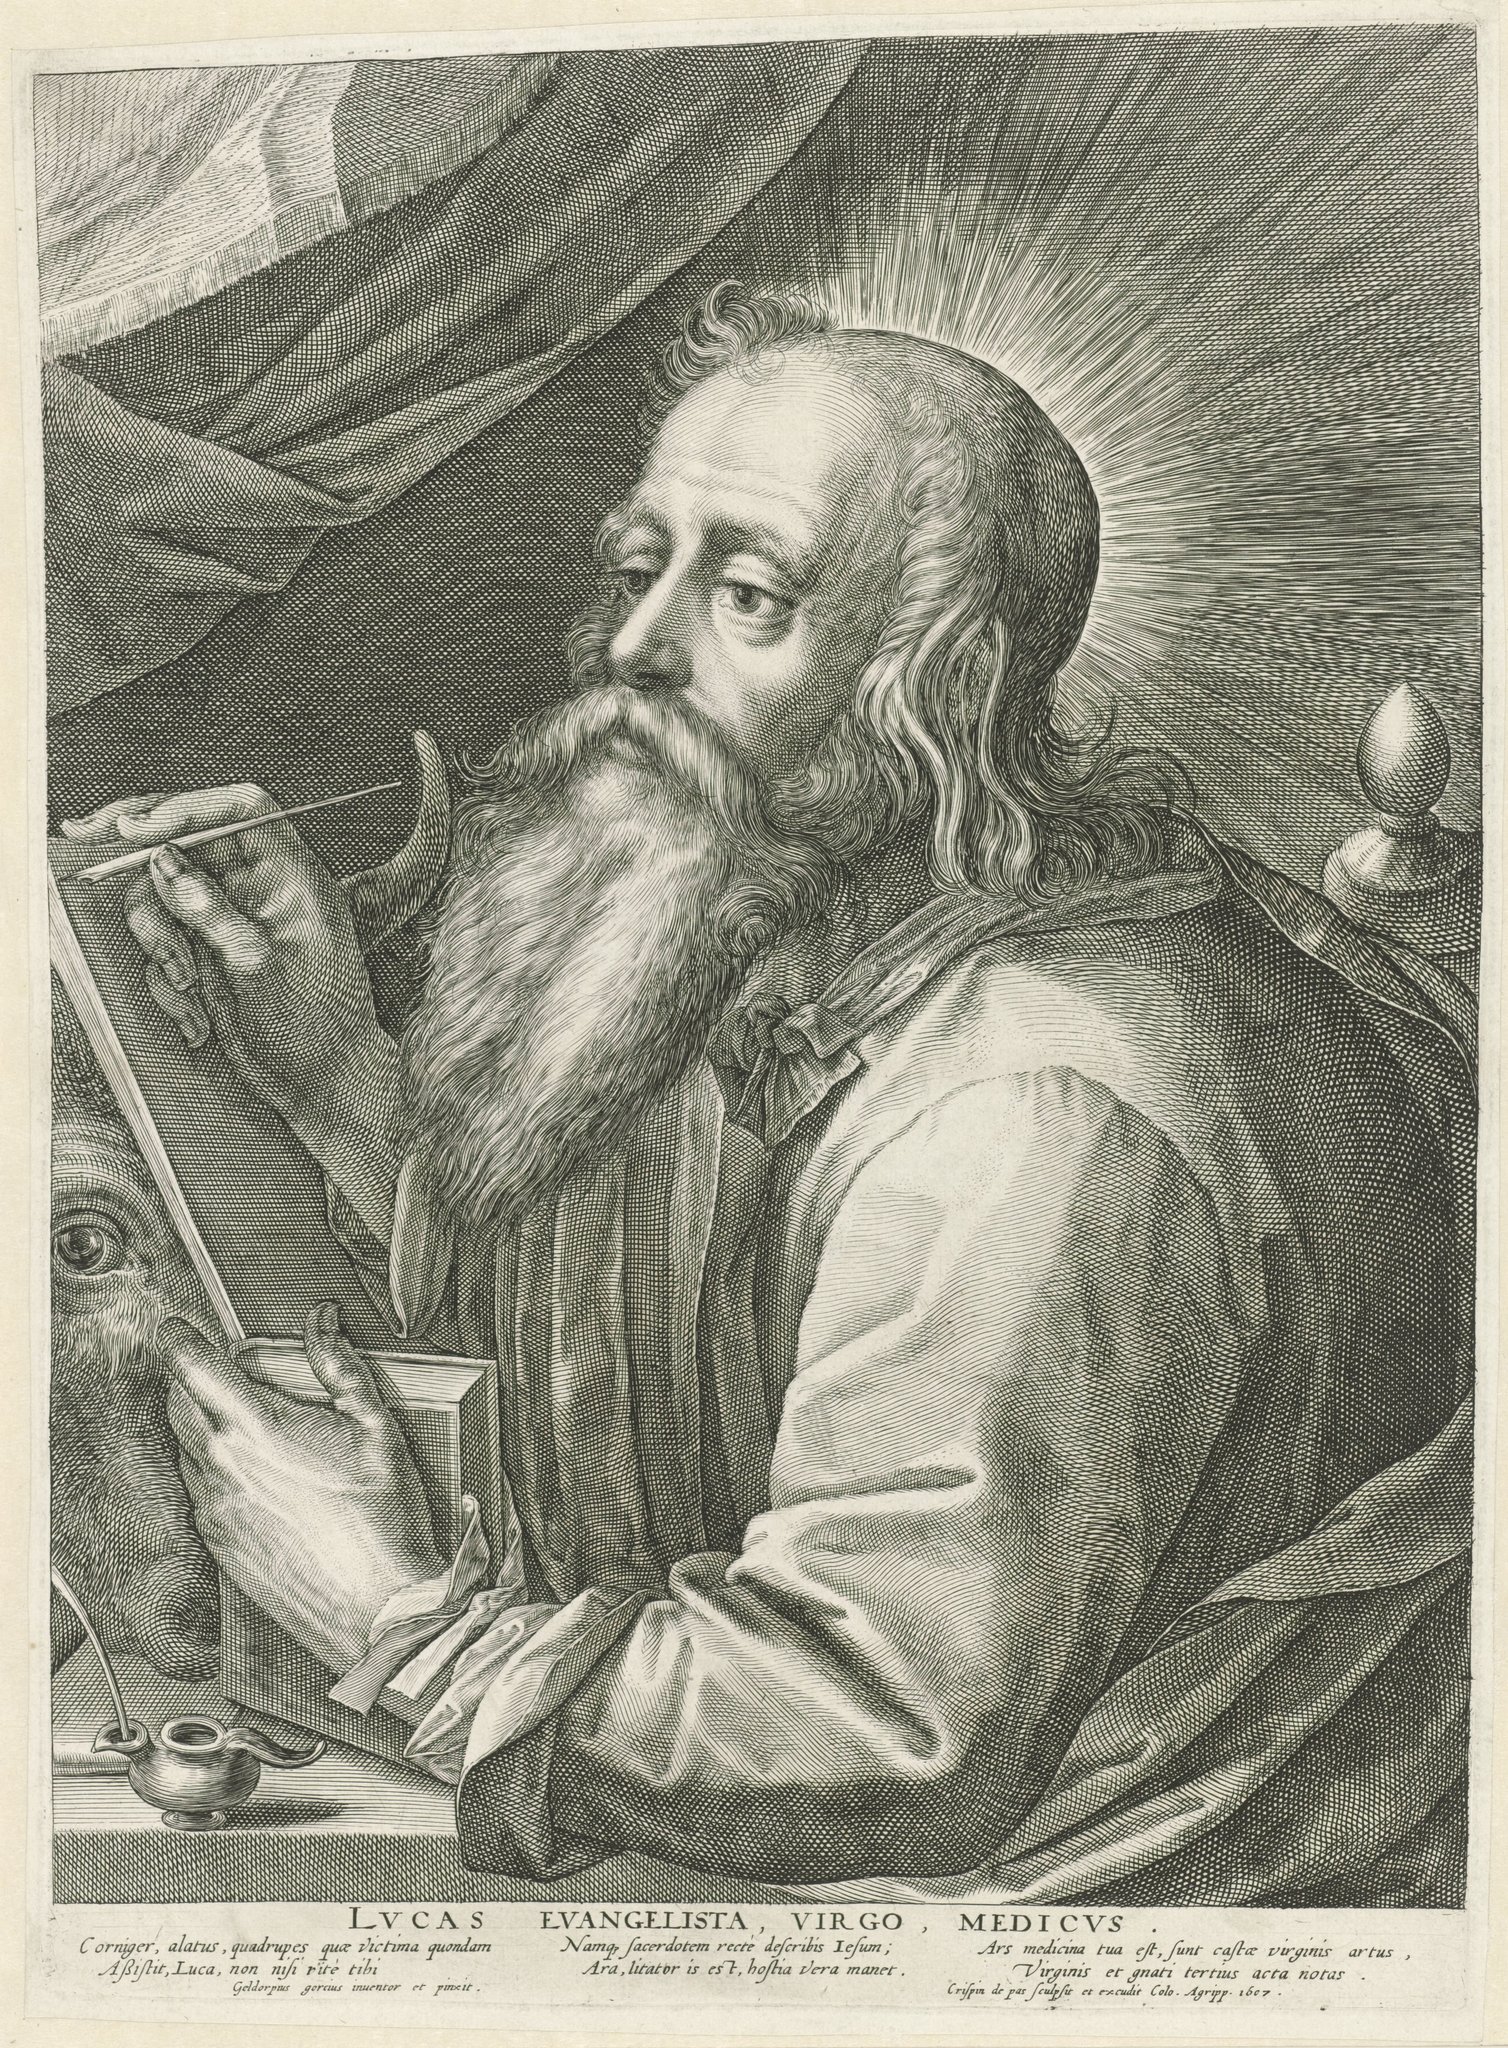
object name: print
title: De evangelist Lucas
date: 1607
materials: paper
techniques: engraving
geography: cologne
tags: luke the evangelist; possible attributes: book, (winged) ox, portrait of the virgin, surgical instruments, painter's utensils, scroll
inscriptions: collector's mark: Lugt 2166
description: Buste van de evangelist Lucas, schilderend. Op de achtergrond zijn attribuut de os. In de marge een zesregelig onderschrift, in drie kolommen, in het Latijn. Prent uit een serie van vier met de evangelisten.